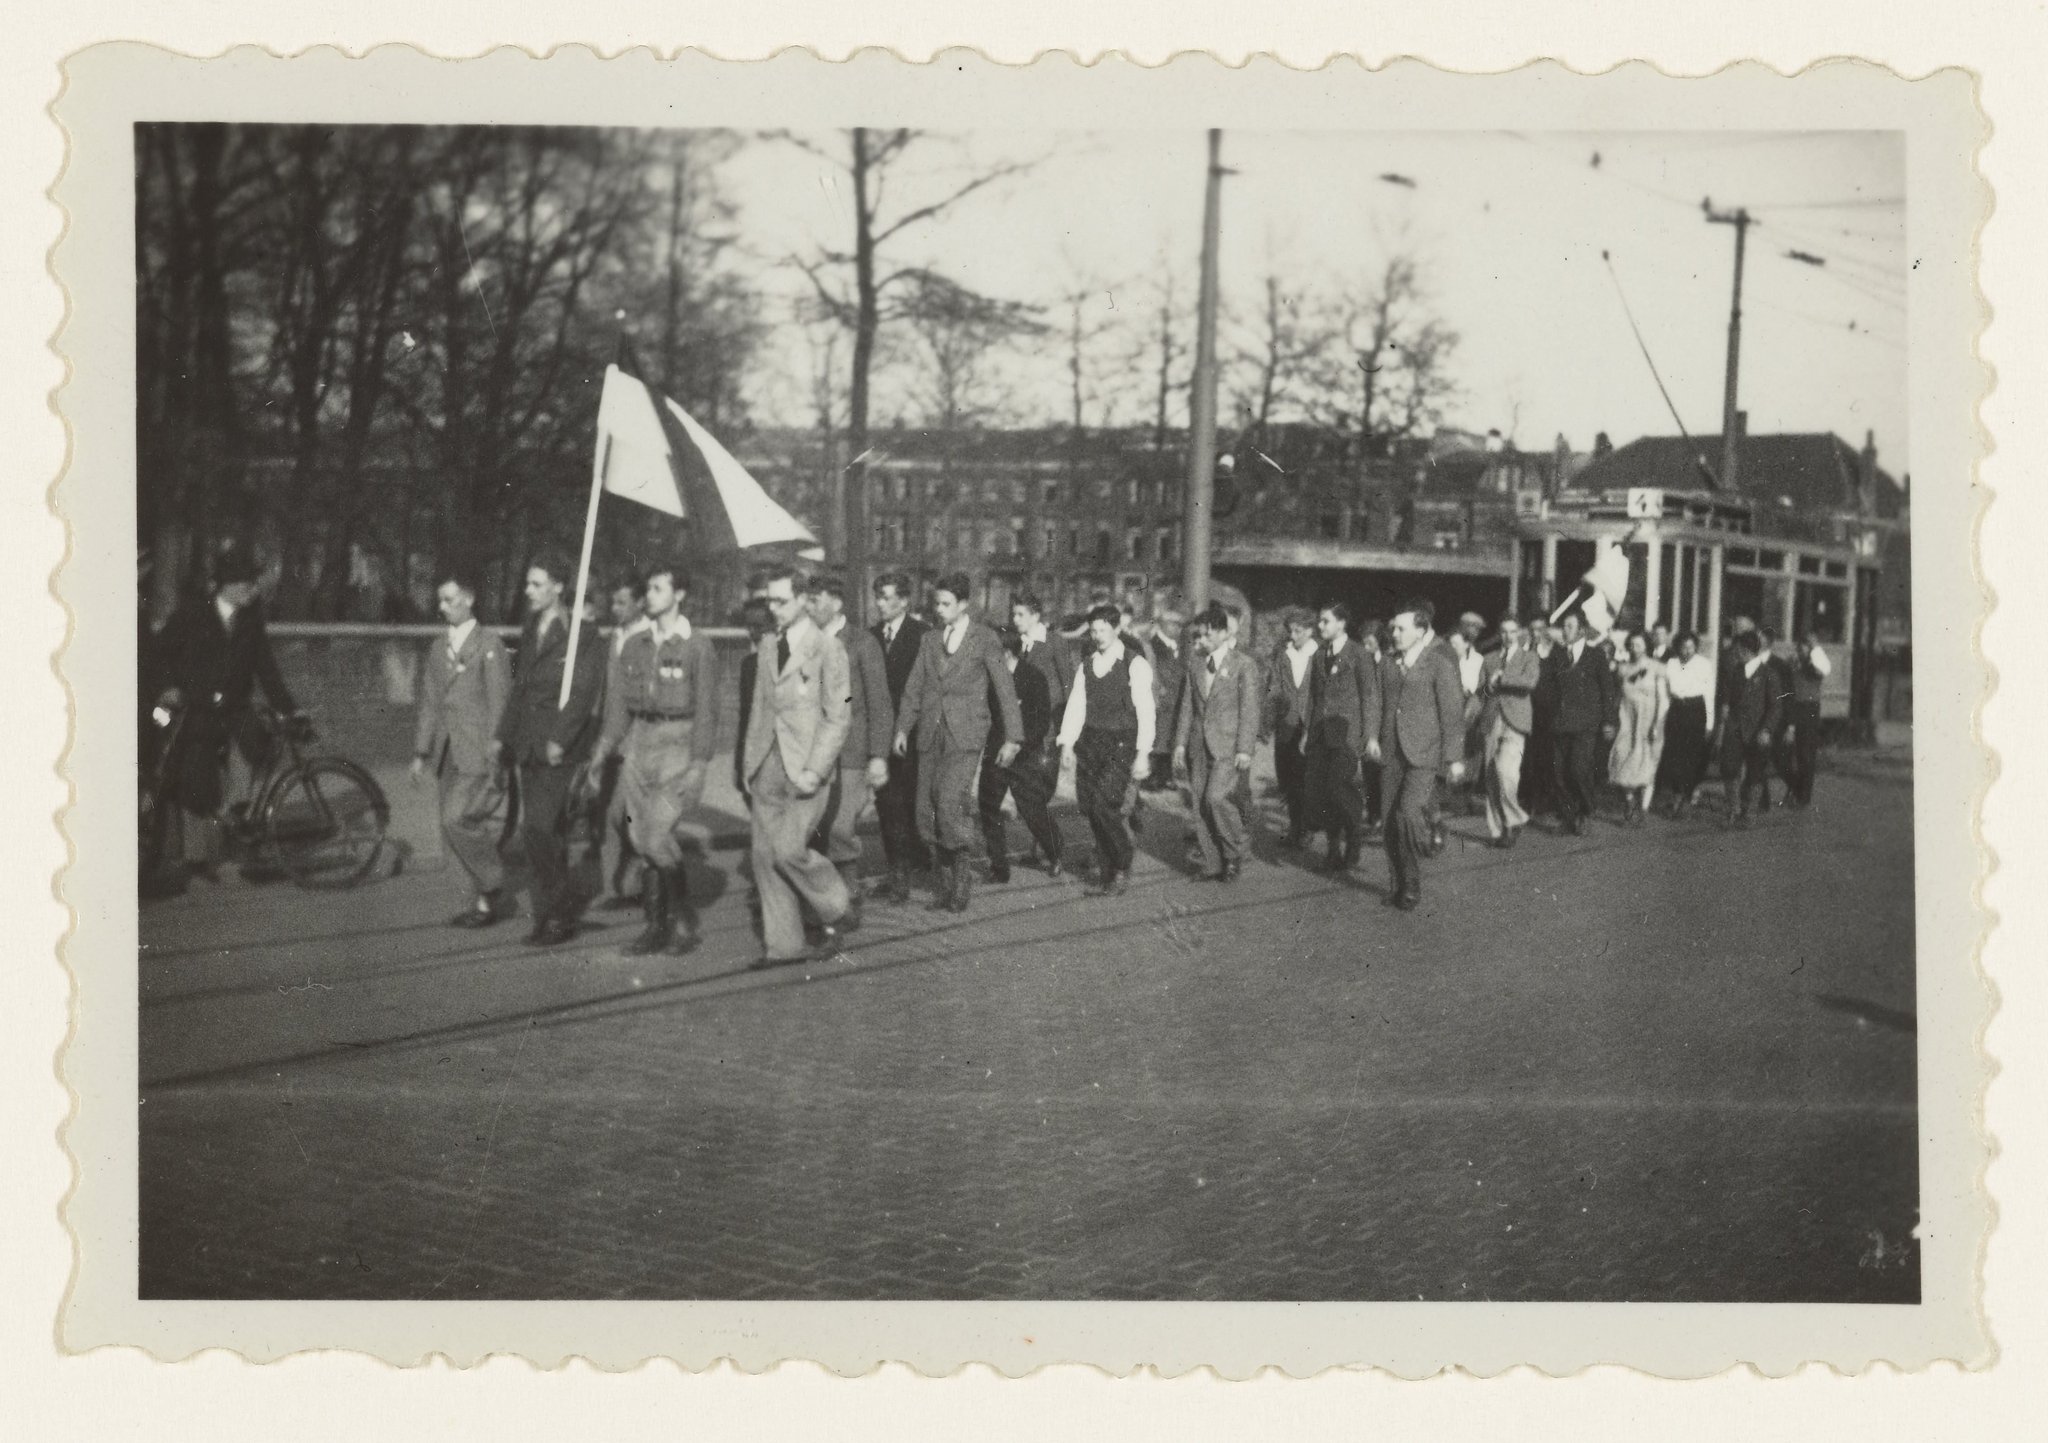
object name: photograph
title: Optocht NSB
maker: Anonymous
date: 1936-1937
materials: photographic support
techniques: gelatin silver print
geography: utrecht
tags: military parade, pageant, amsterdam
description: Optocht van de NSB. Voorop een man met de Nederlandse vlag. Niemand is in uniform, wel hebben sommigen hoge laarzen aan. Op de achtergrond een tram, lijn 4. Vanaf 1936 gold voor de NSB en aan hen verwante organisaties een verbod om in uniform op straat te verschijnen.